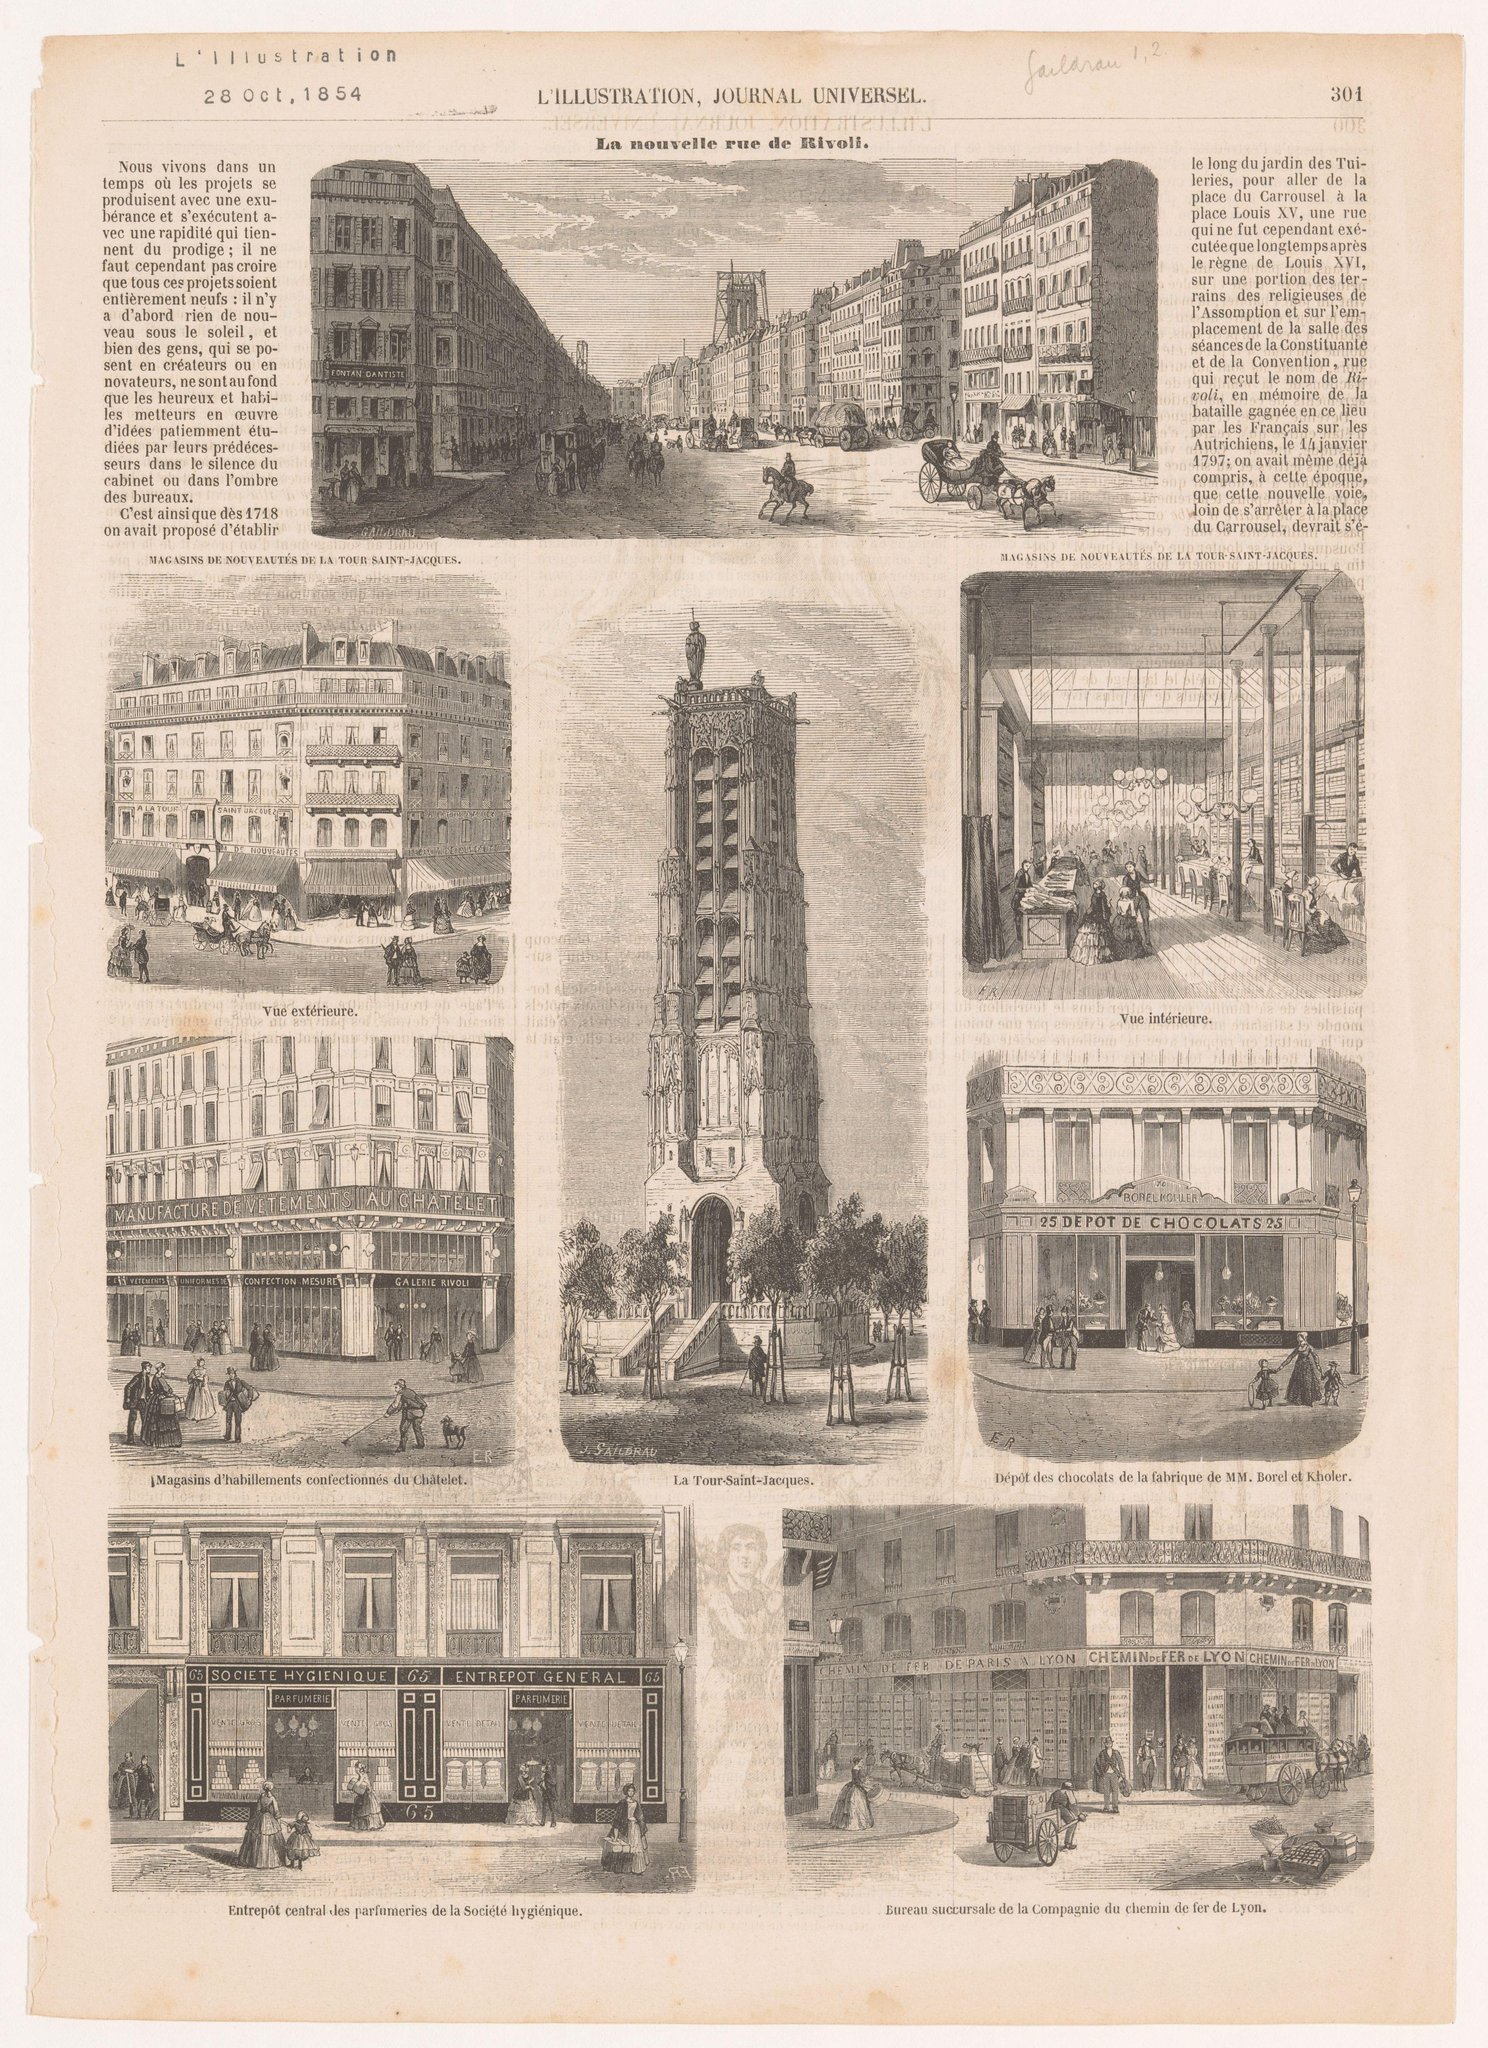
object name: print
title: Pagina uit L'Illustration met acht afbeeldingen van gezichten op de Rue de Rivoli te Parijs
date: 1854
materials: paper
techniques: letterpress printing, engraving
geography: paris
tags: shop, store, street, shop-window, show-window, paris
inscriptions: monogram: ‘ER’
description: Prent uit: L'Illustration, vol. 24, nr. 609, 28 oktober 1854, p. 301.